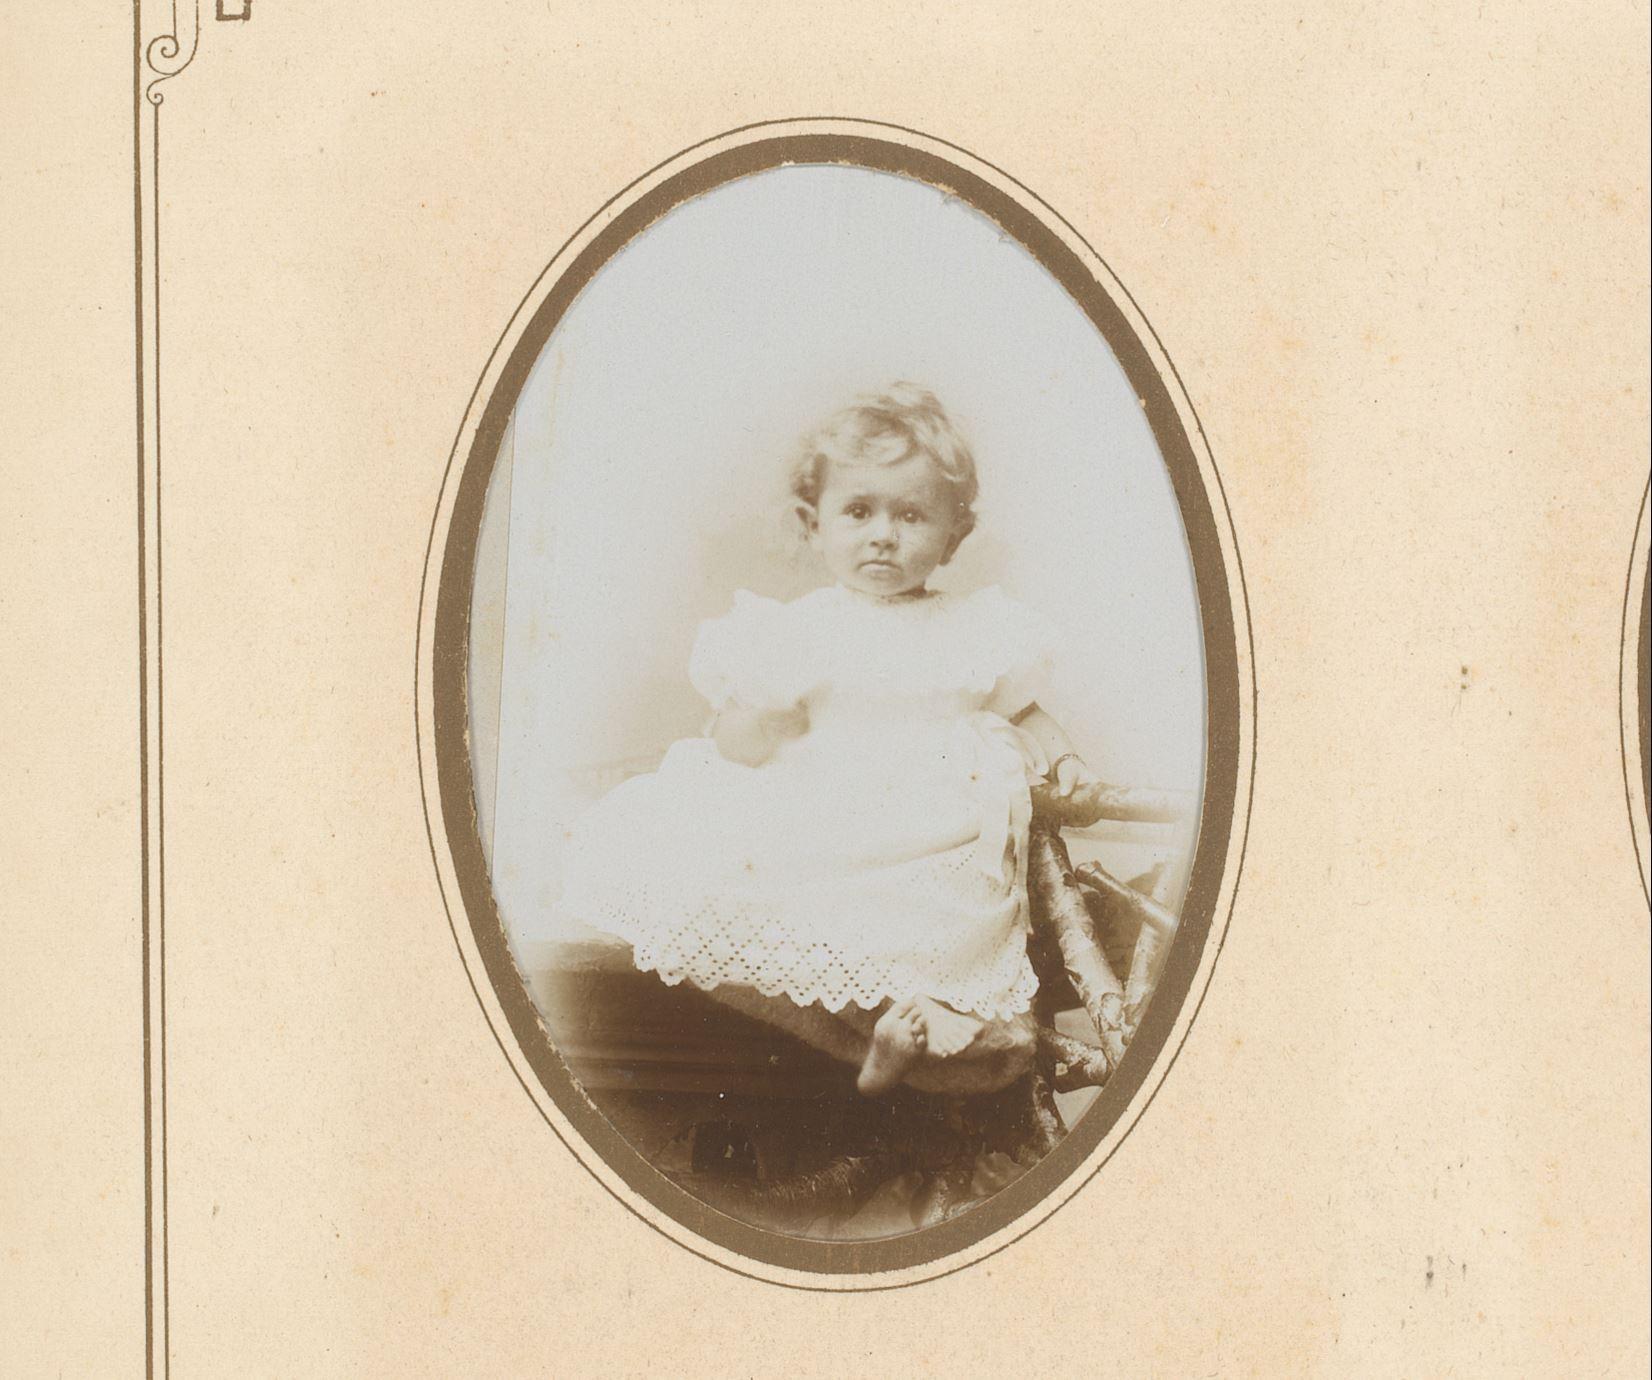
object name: carte de visite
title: Portret van een kleuter in gehaakte jurk, zittend op een hek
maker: theodorus ferdinant van de pol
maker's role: fotograaf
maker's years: 1861-1953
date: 1900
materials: cardboard, photographic support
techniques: collodion silver print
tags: toddler, sitting figure, historical persons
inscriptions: annotation: ‘1 nov 1900/ Klein Rietje’, inscription: ‘Th. F. v.d. Pol/ Amersfoort’